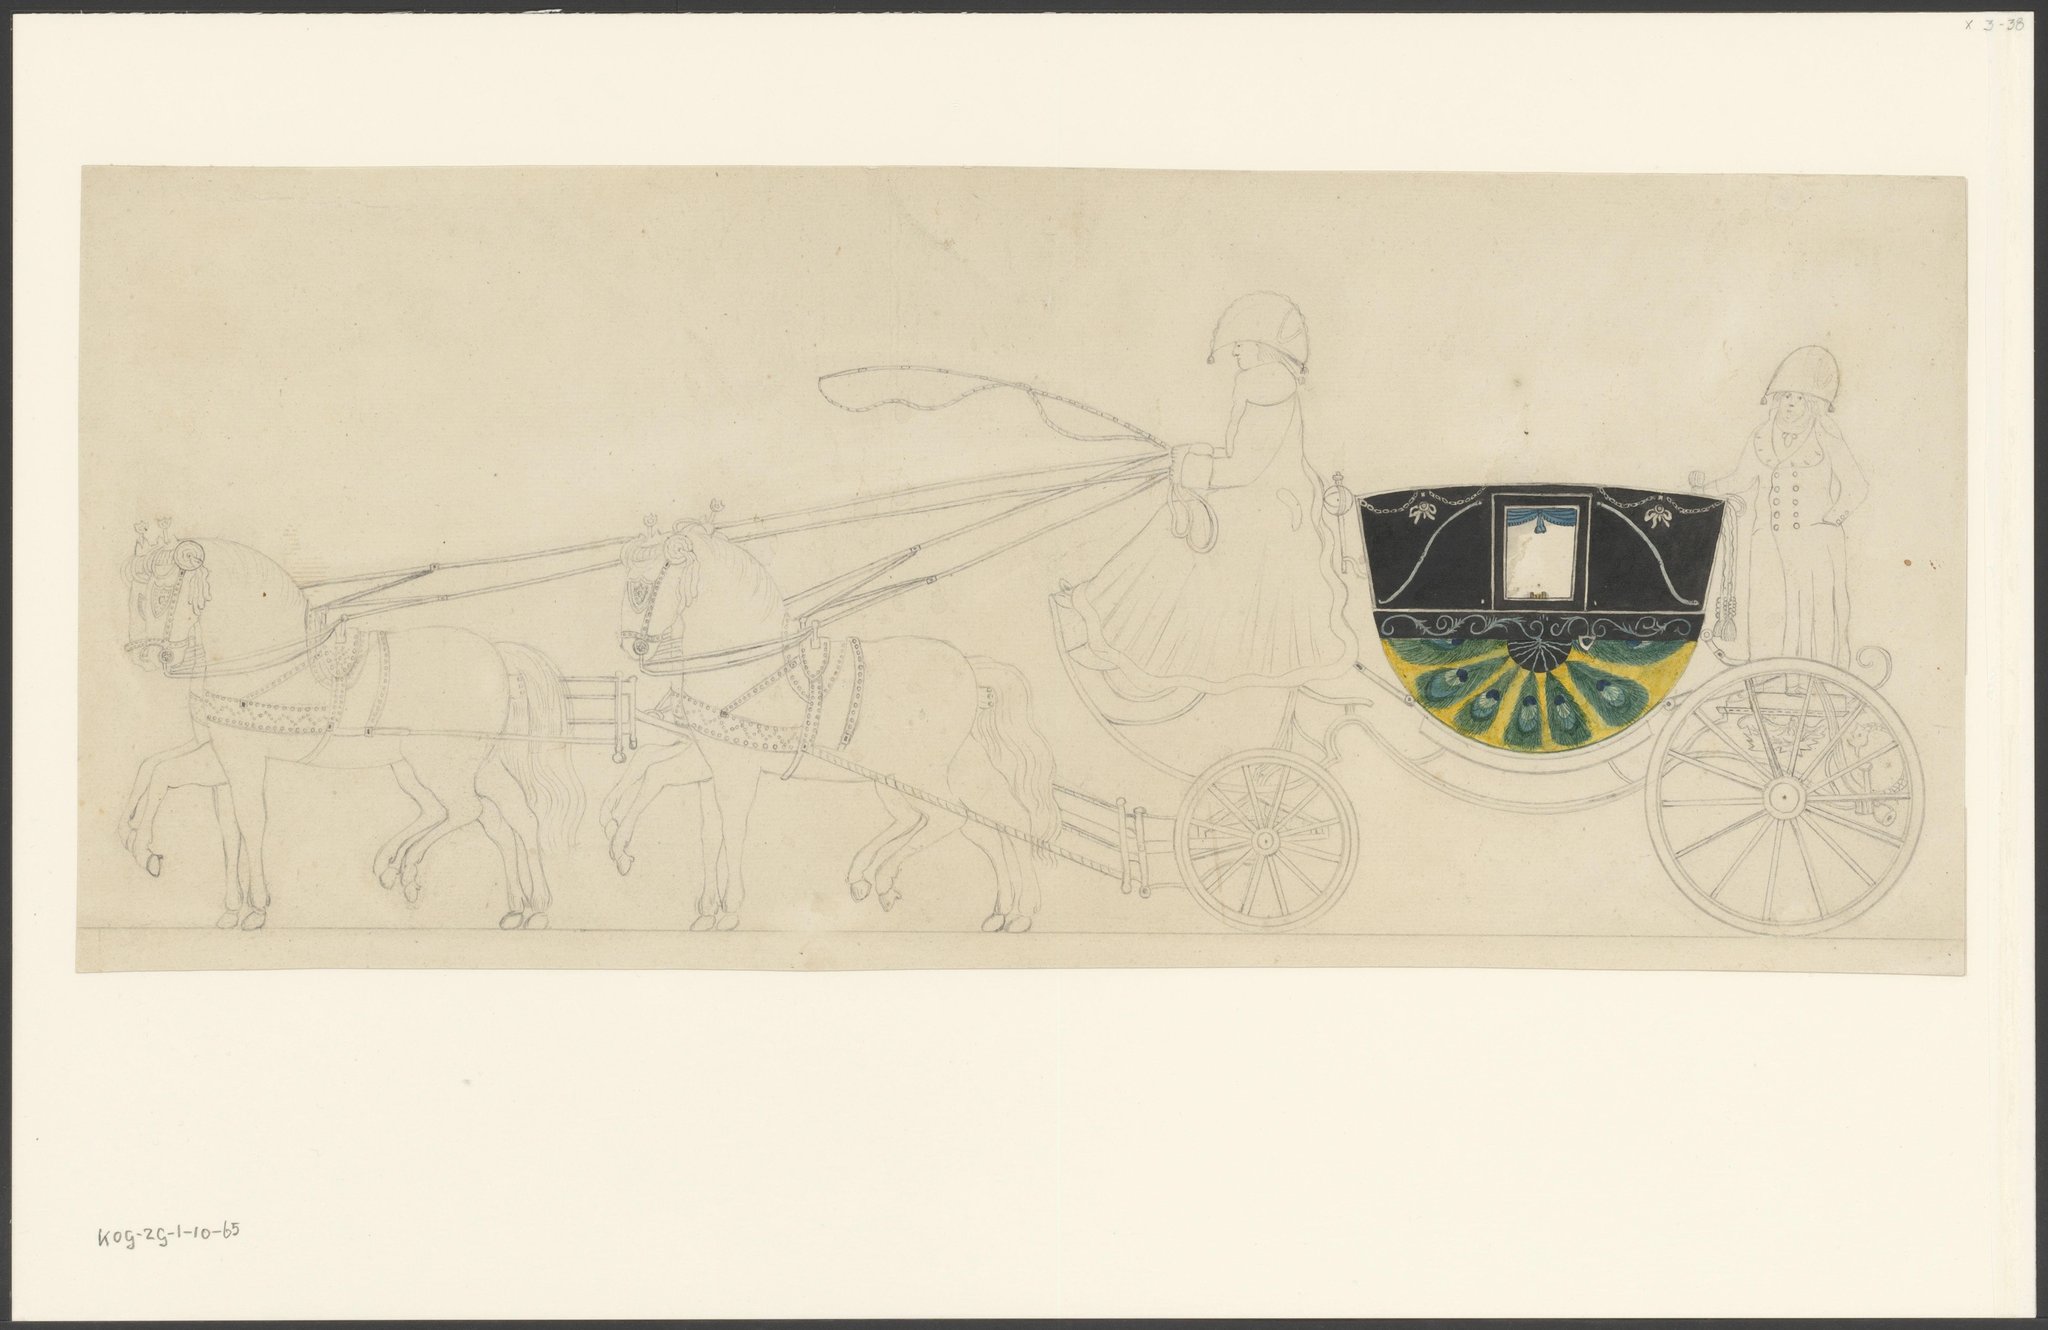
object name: drawing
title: Gesloten koets getrokken door vier paarden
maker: Anonymous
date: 1750-1849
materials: paint, ink, paper, pencil, watercolor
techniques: brush, pen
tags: four-wheeled vehicle drawn by more than three animals, whip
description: De koets is van het type Berline, een gesloten koets met ruimte voor vier tot zes personen. De koets is zwart met onderaan pauwenveren in kleur. Tekening is niet volledig ingekleurd. Onderwerpsrubrieken binnen de Atlas Zeden en Gewoonten: Handel, nijverheid en verkeer, Vervoermiddelen te land en te water, vervoermiddelen te land, Rijtuigen en Statiekarossen.